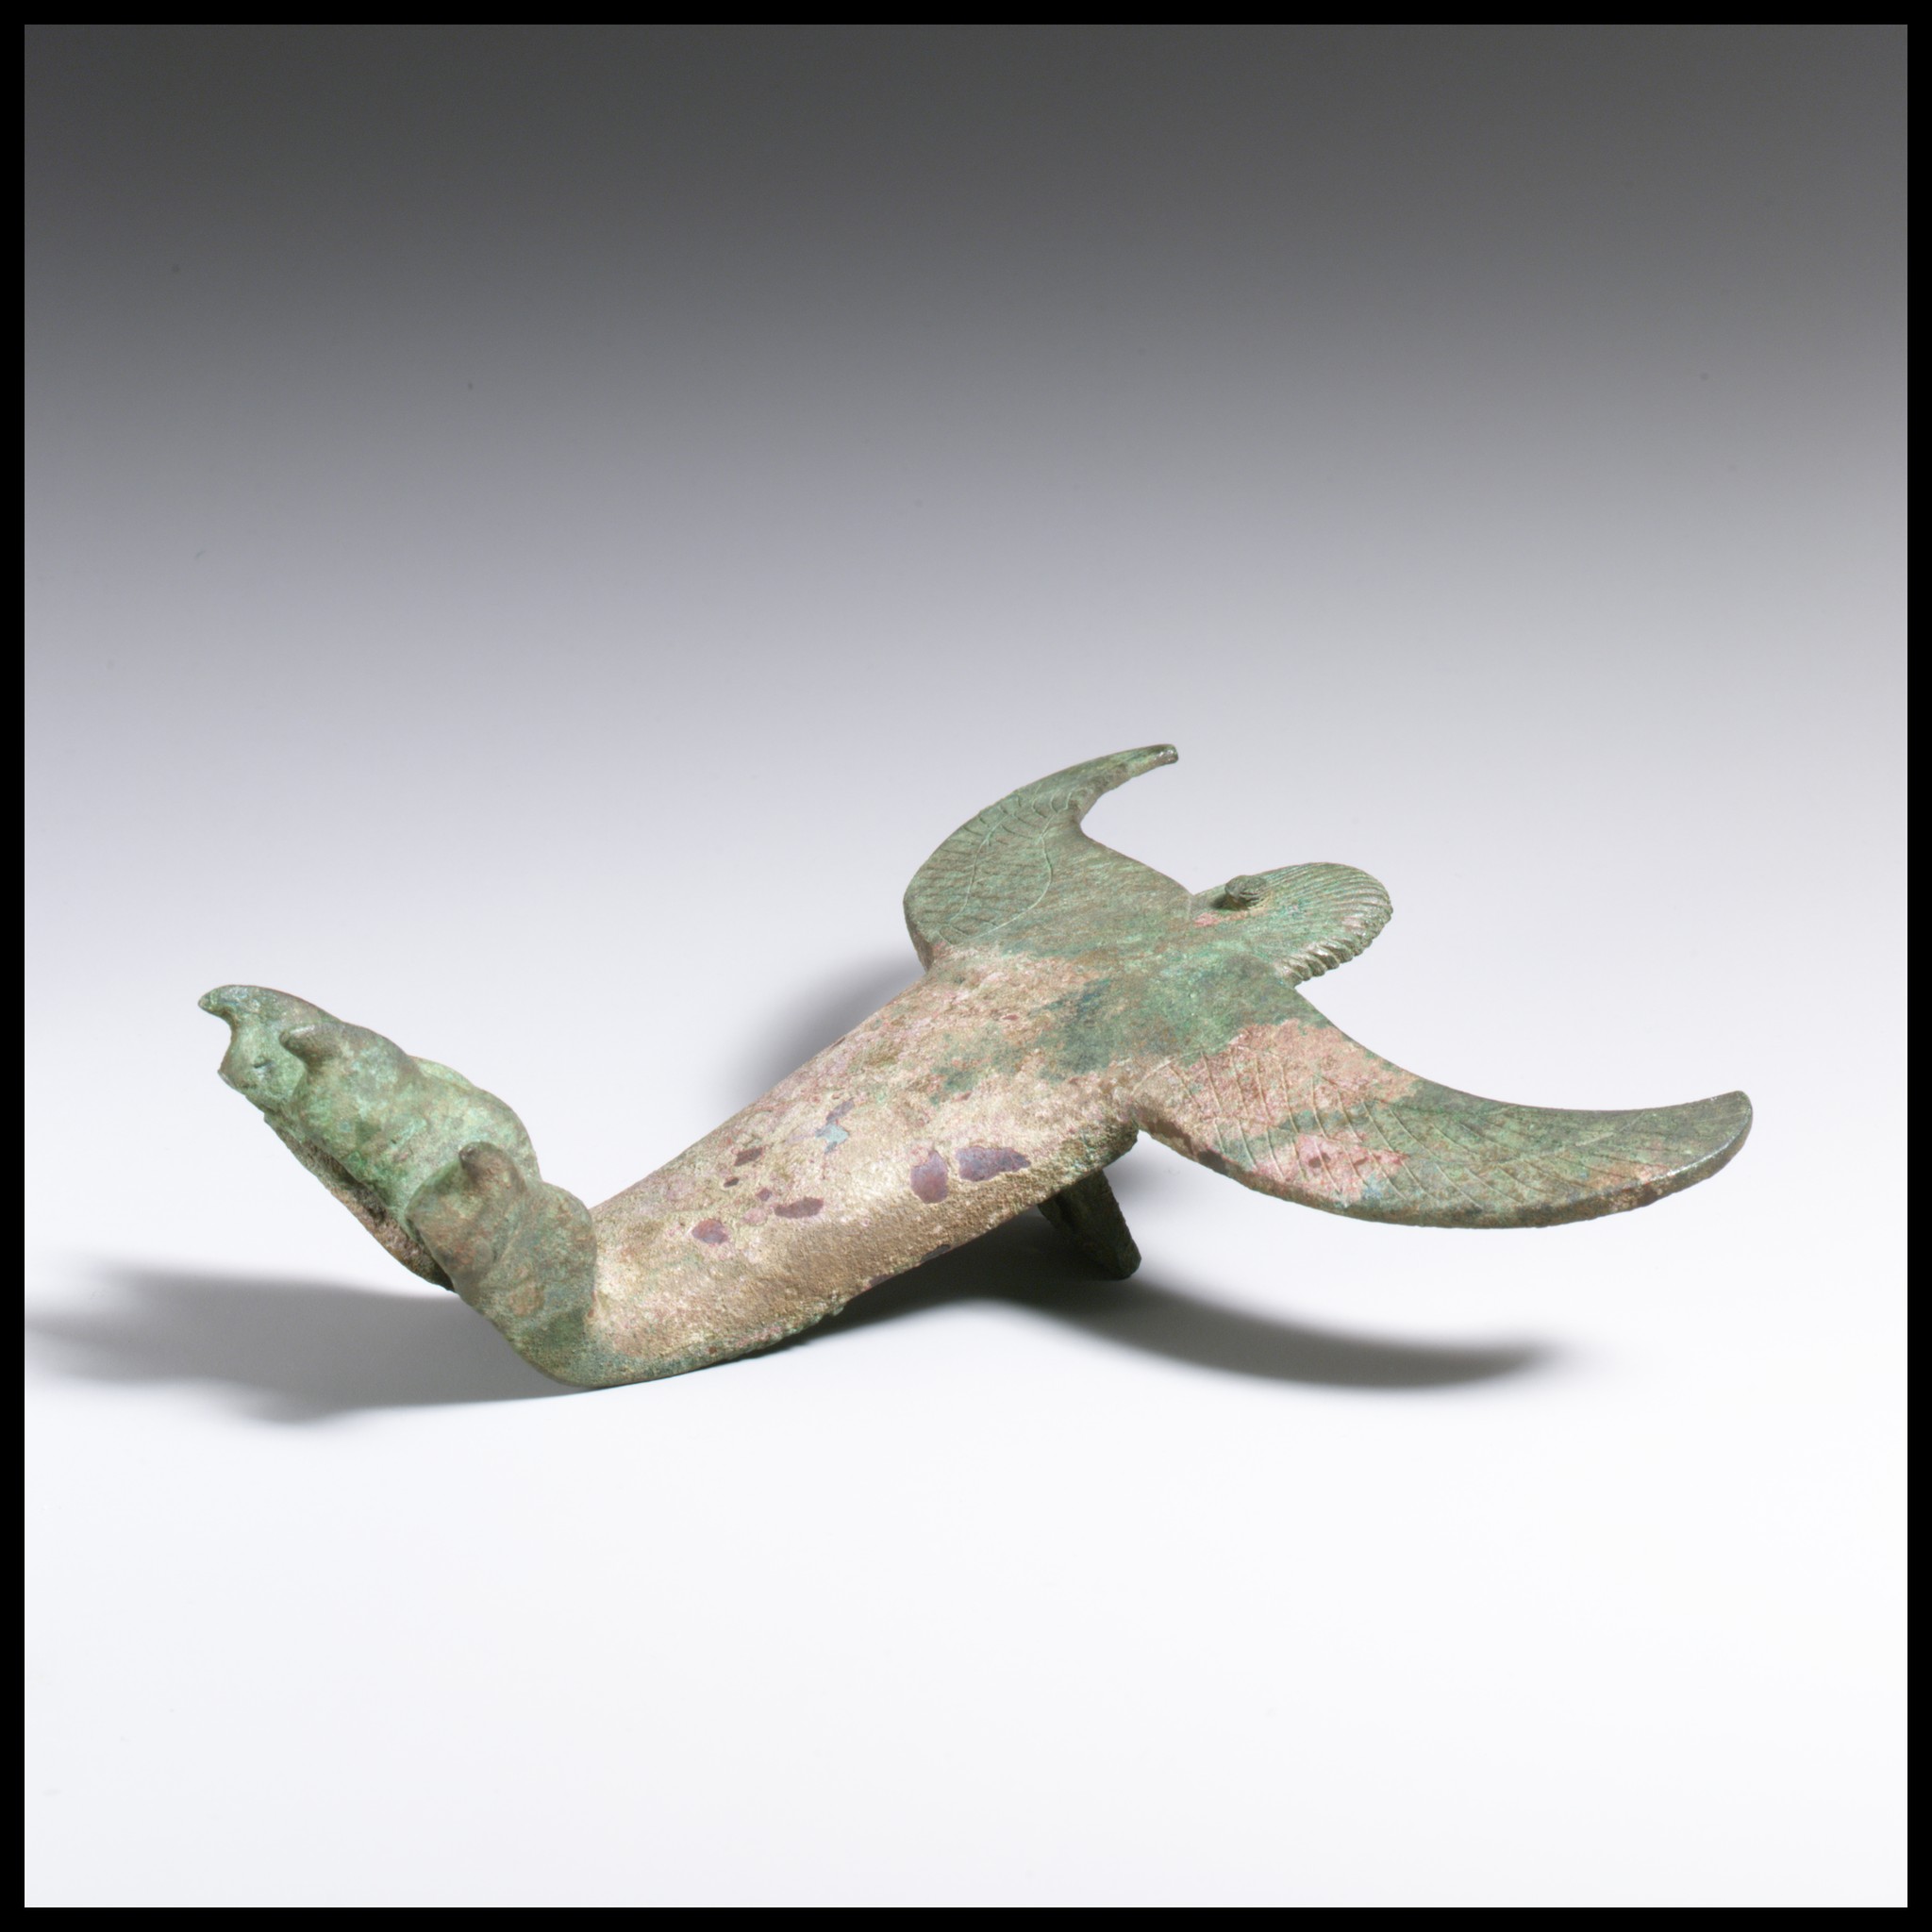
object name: bowl with foot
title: Bowl, foot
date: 7000 BCE-330 CE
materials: bronze